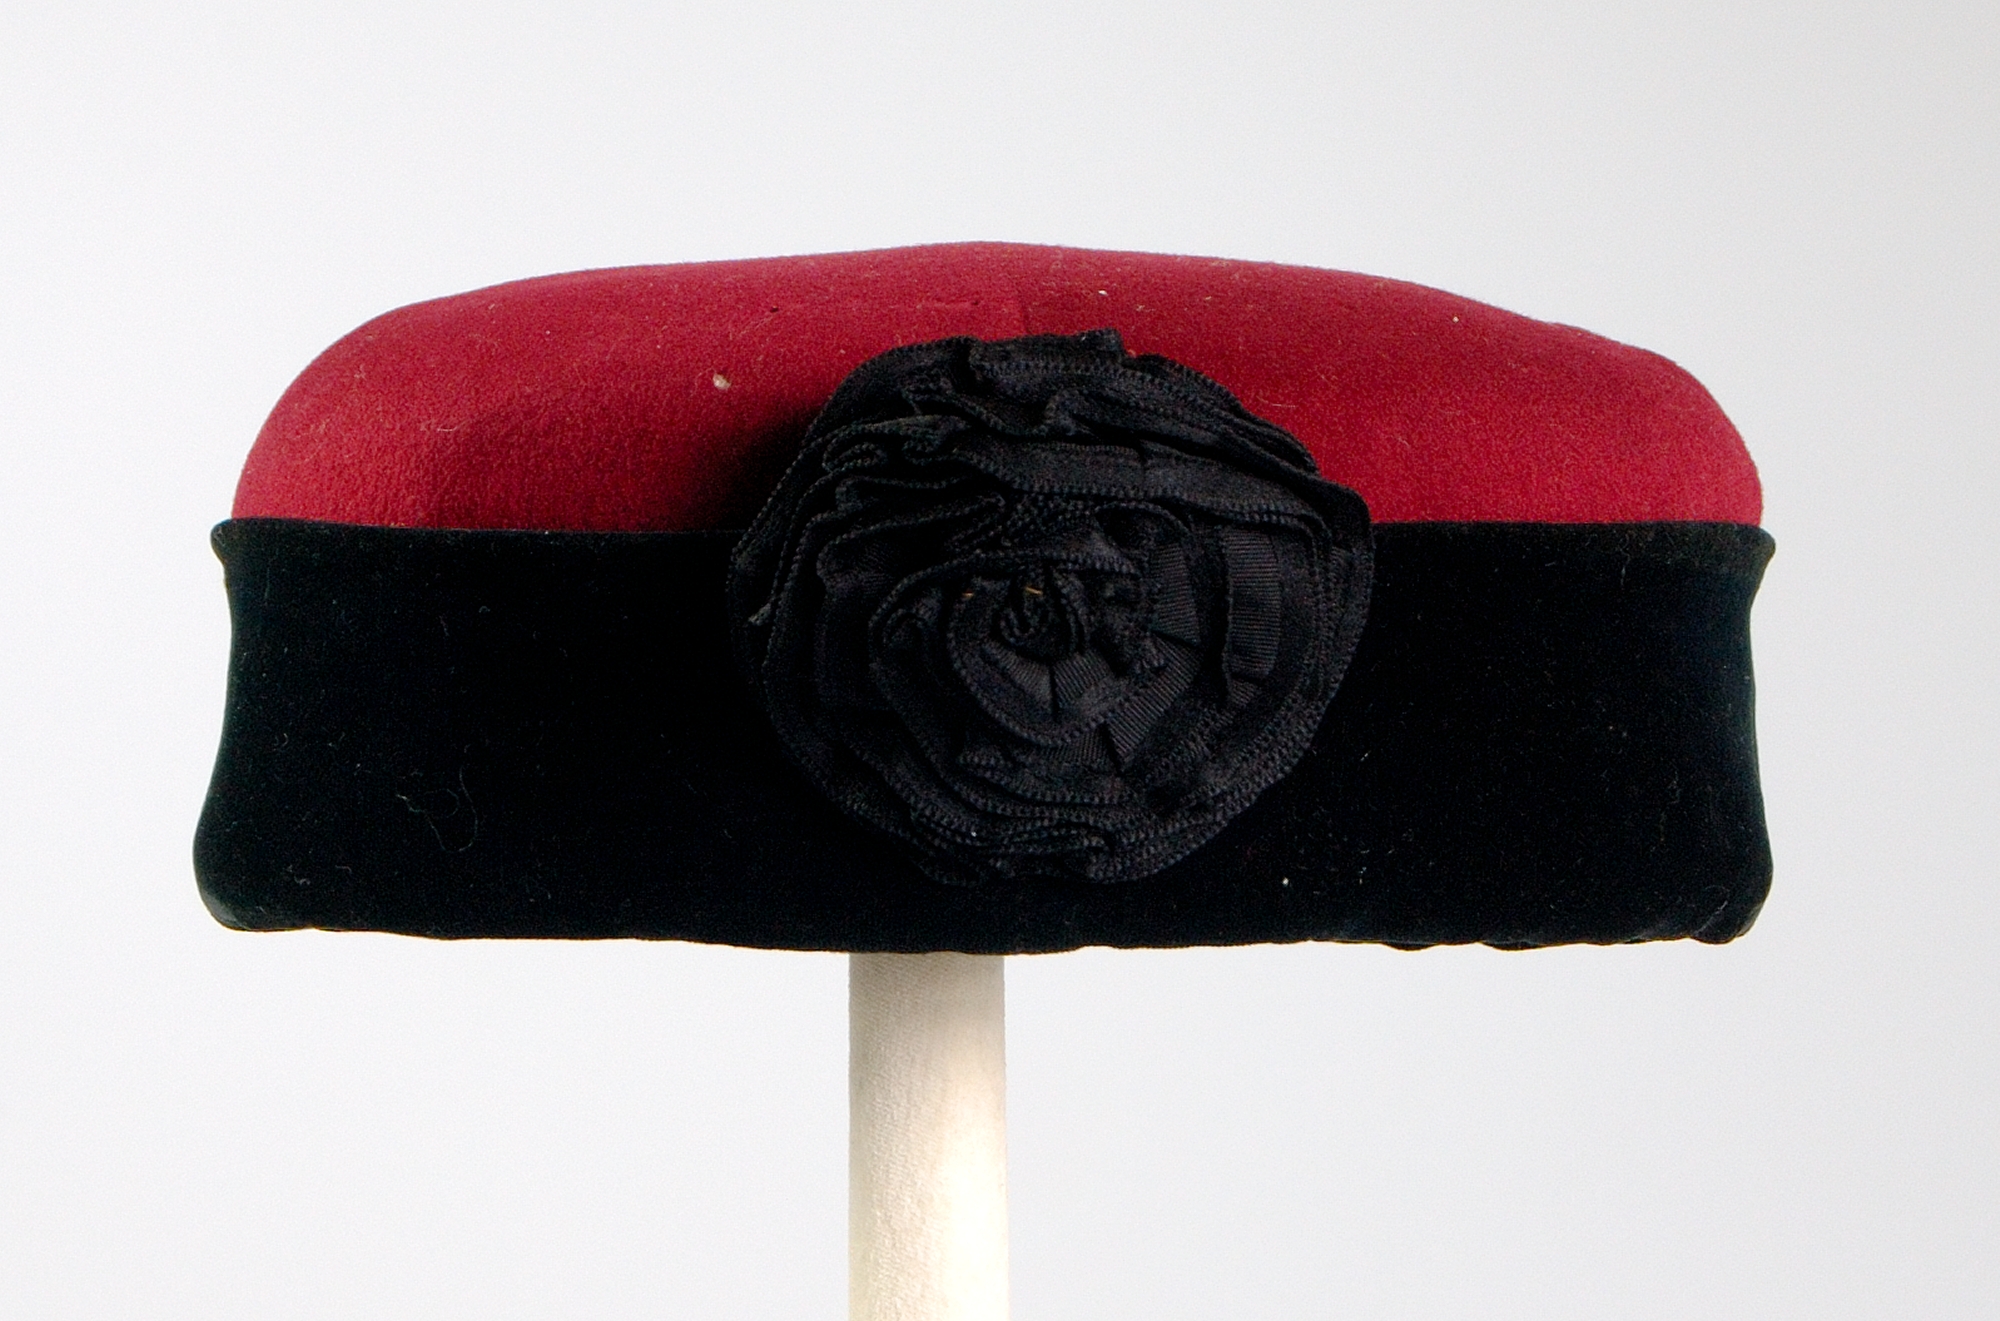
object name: hat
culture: american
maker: frederick loeser & company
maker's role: department store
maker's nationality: american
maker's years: 1860-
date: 1884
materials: silk, wool